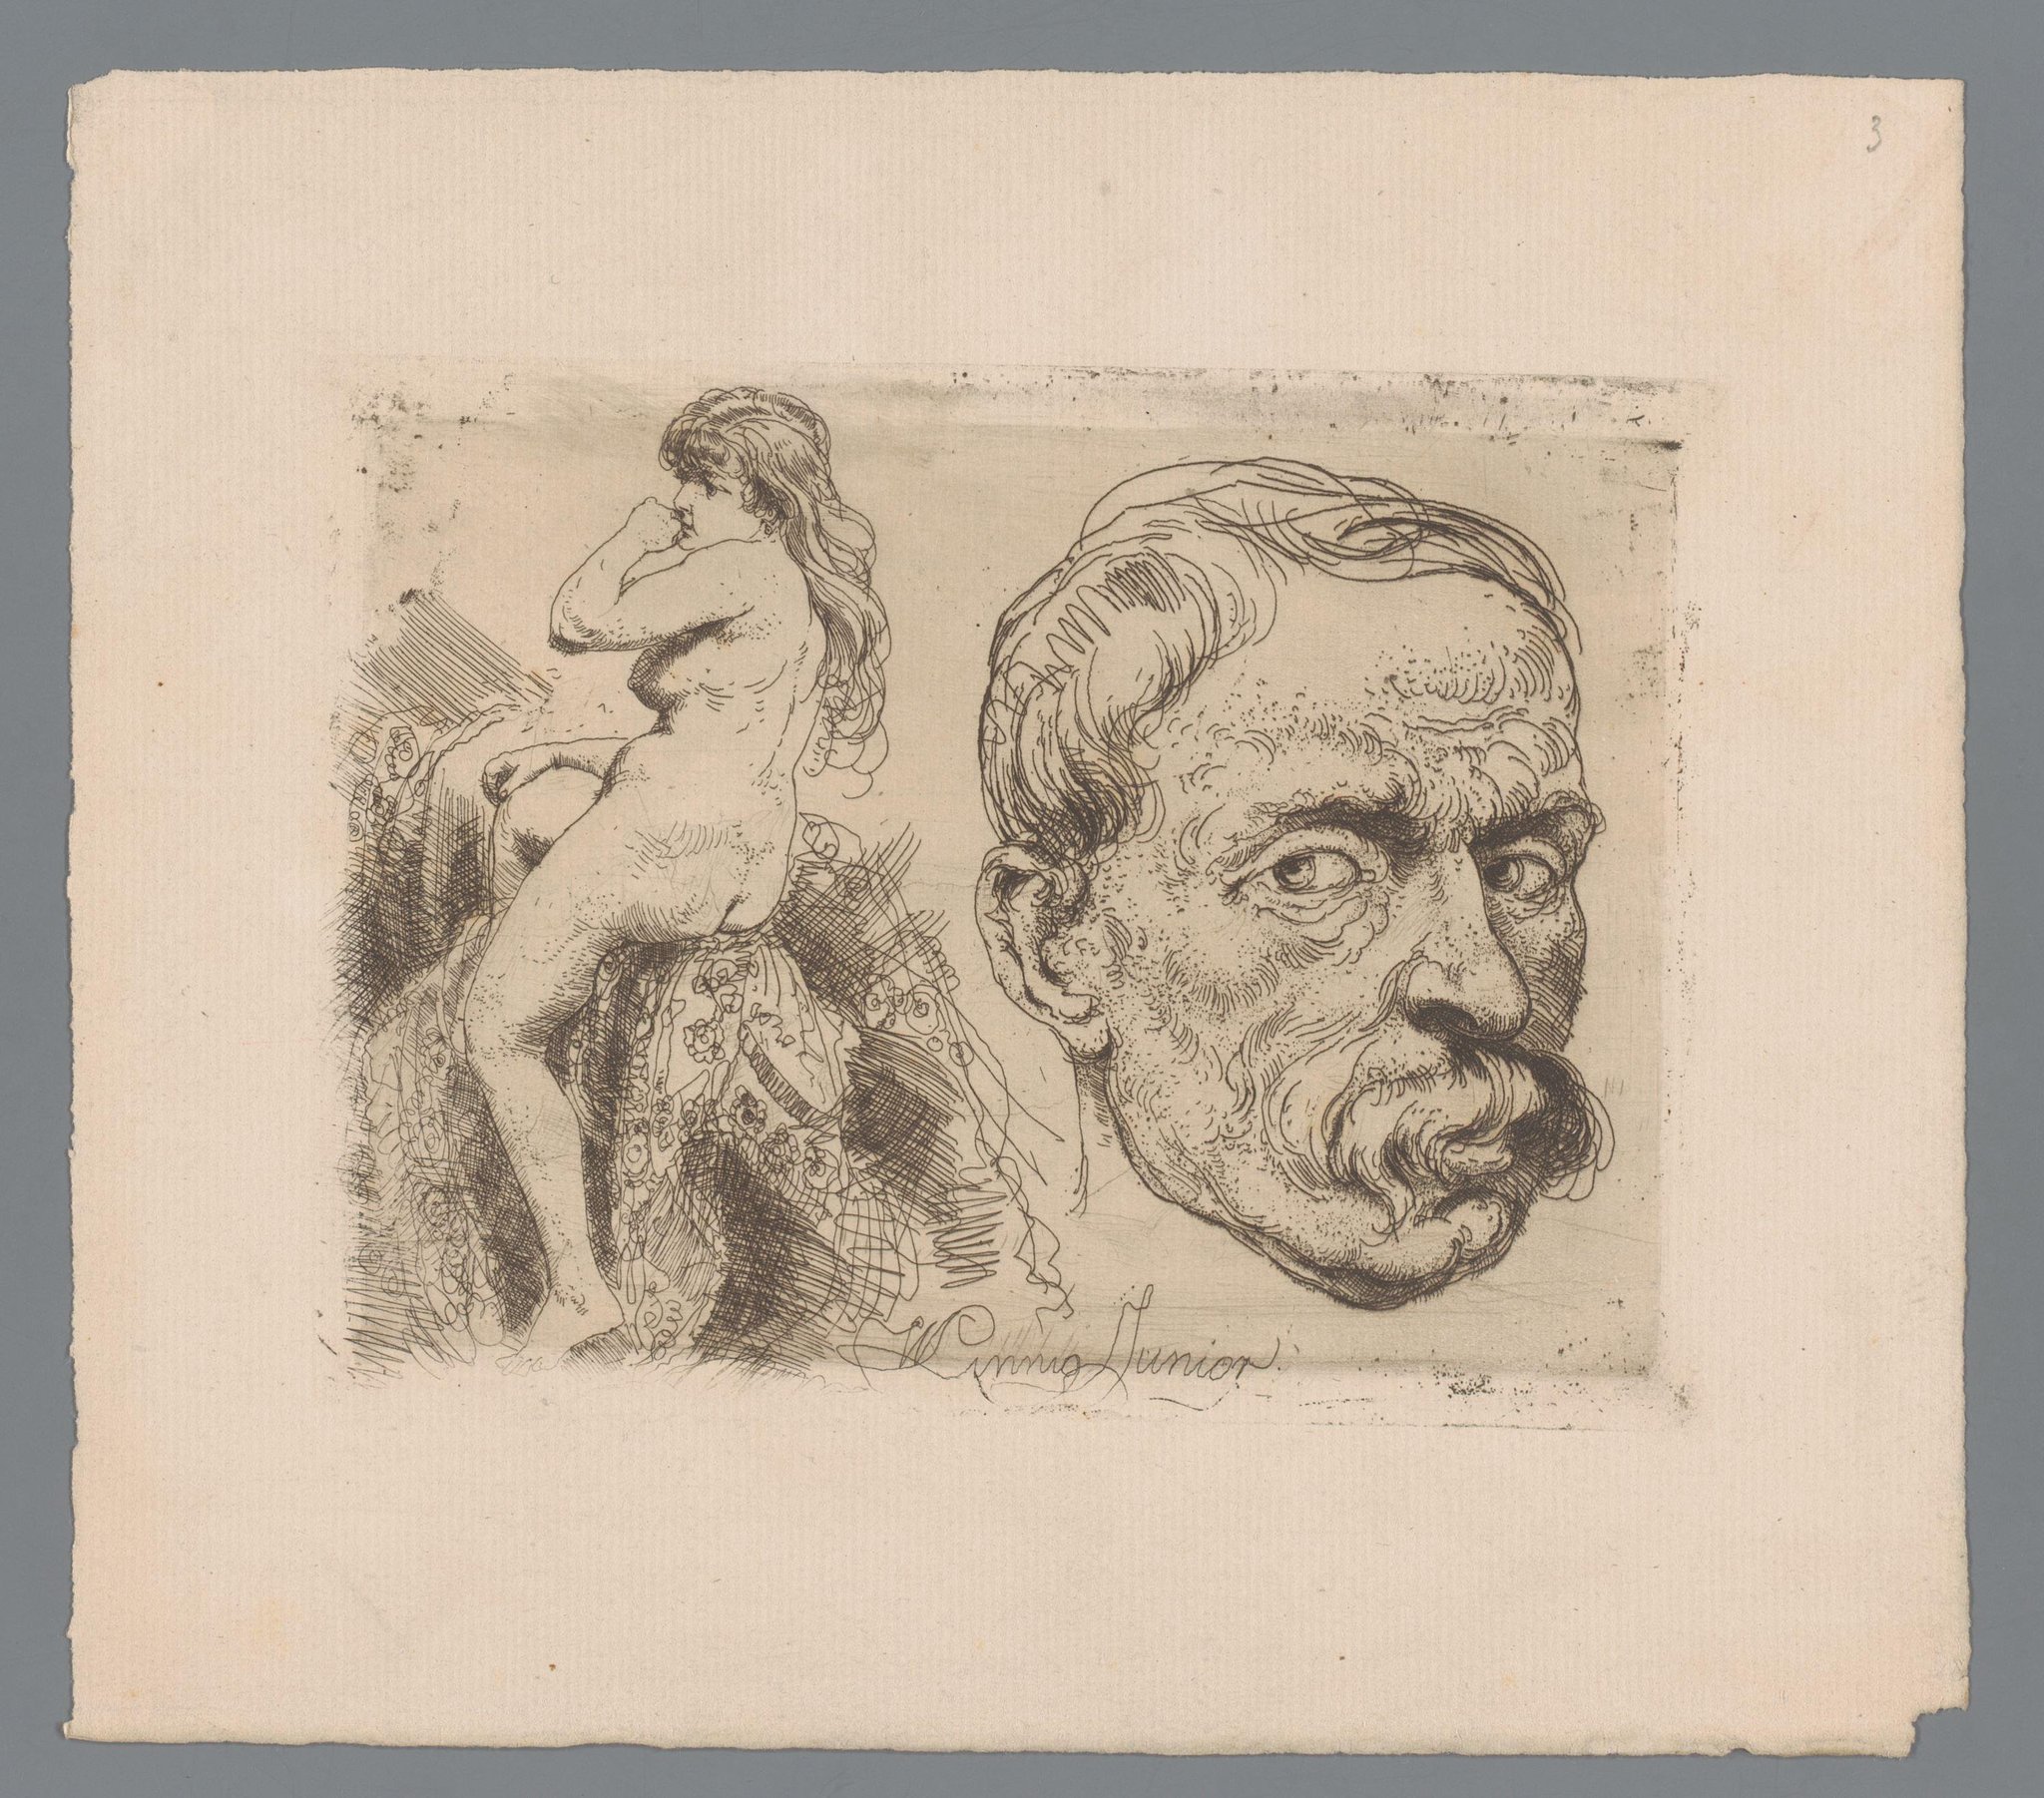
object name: print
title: Studieblad met zittende naakte vrouw en portret van een onbekende man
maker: willem linnig (ii)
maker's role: print maker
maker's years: 1842-1890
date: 1852-1890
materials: paper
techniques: etching, intaglio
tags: anonymous historical person portrayed alone, woman (showing herself) undressed, quasi-nude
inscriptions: collector's mark, `: Lugt 2228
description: Deze plaat is later versneden, voor het linkerdeel zie RP-P-1912-927.